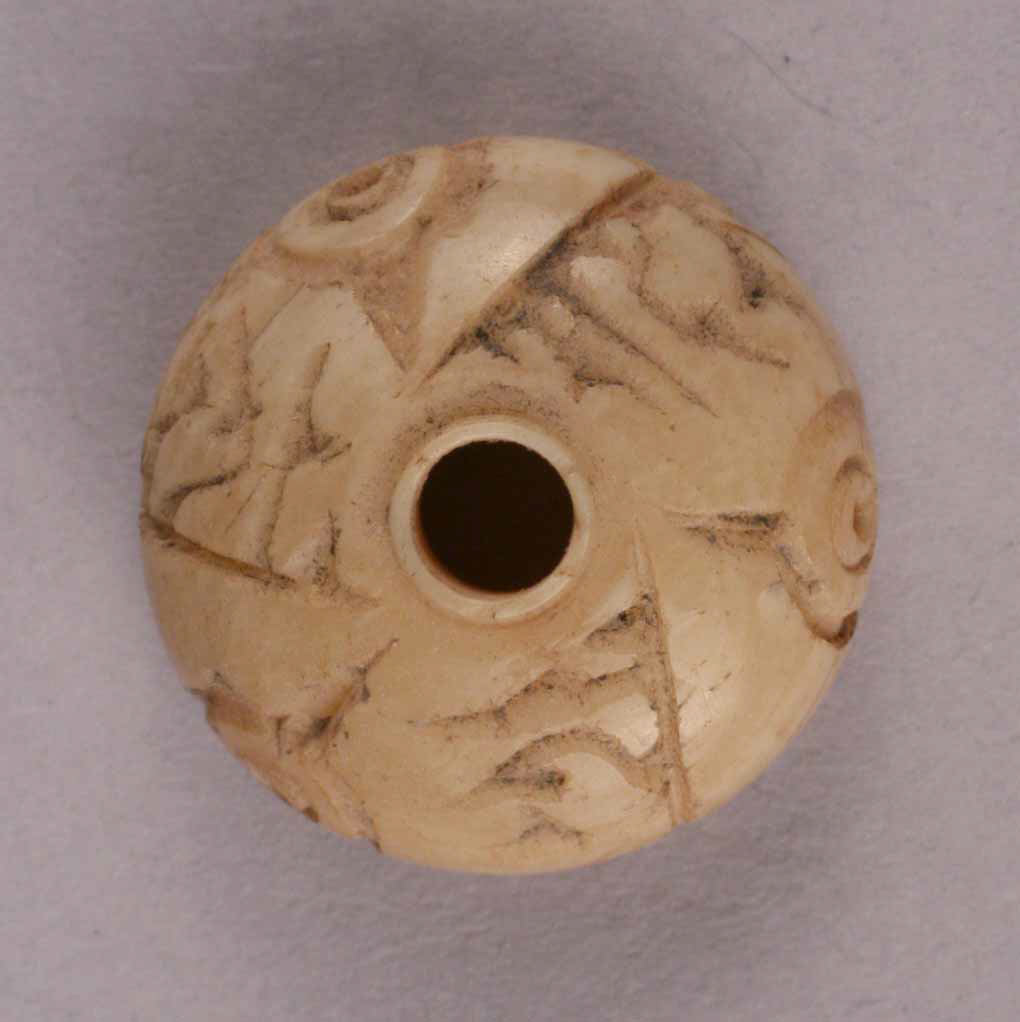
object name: button or bead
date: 801-1000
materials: bone, paint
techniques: incising, inlay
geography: iran